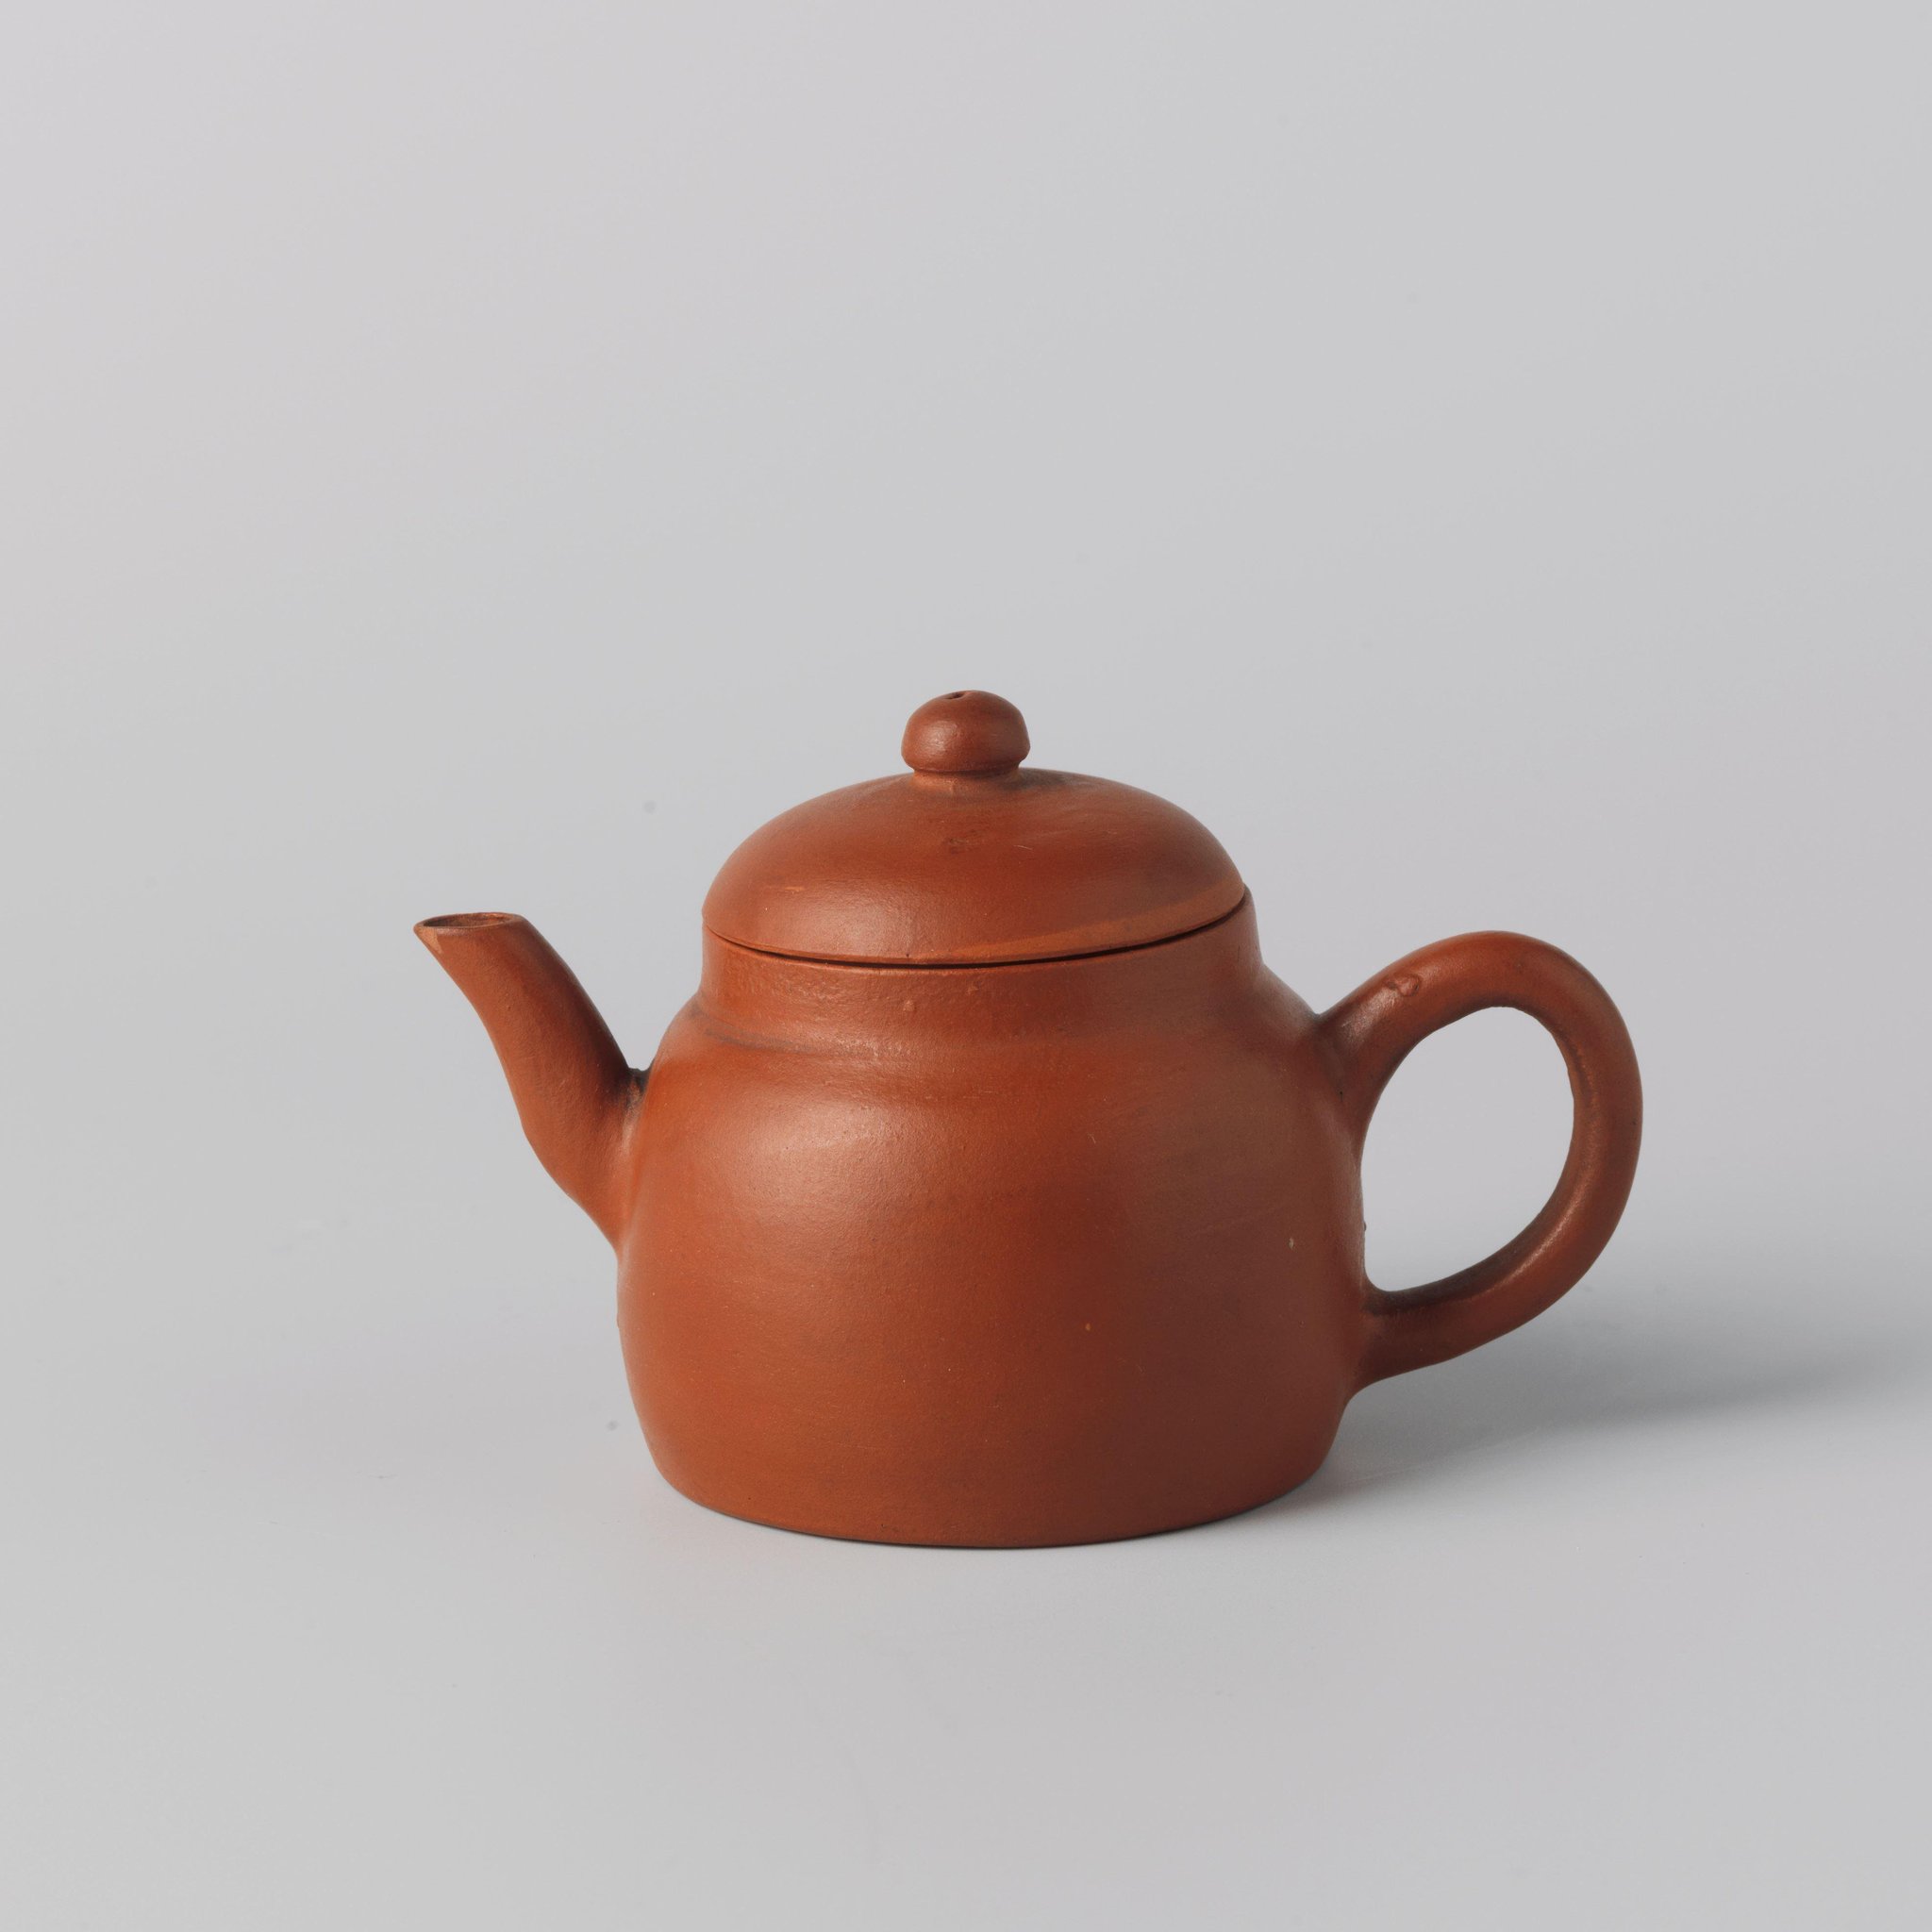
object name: teapot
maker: Anonymous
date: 1800-1899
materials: glaze, porcelain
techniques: firing, turning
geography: china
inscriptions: inscription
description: This refined red stoneware teapot received an additional layer of clay to emulate the colour of Yixing teapots. Beginning in the 18th century, the Chaozhou and Shantou regions of Guangdong province began making teapots mimicking the stoneware produced in Yixing. While most of the teapots originating from Guangdong are coarser than their Yixing counterparts, this teapot stands as an exception.